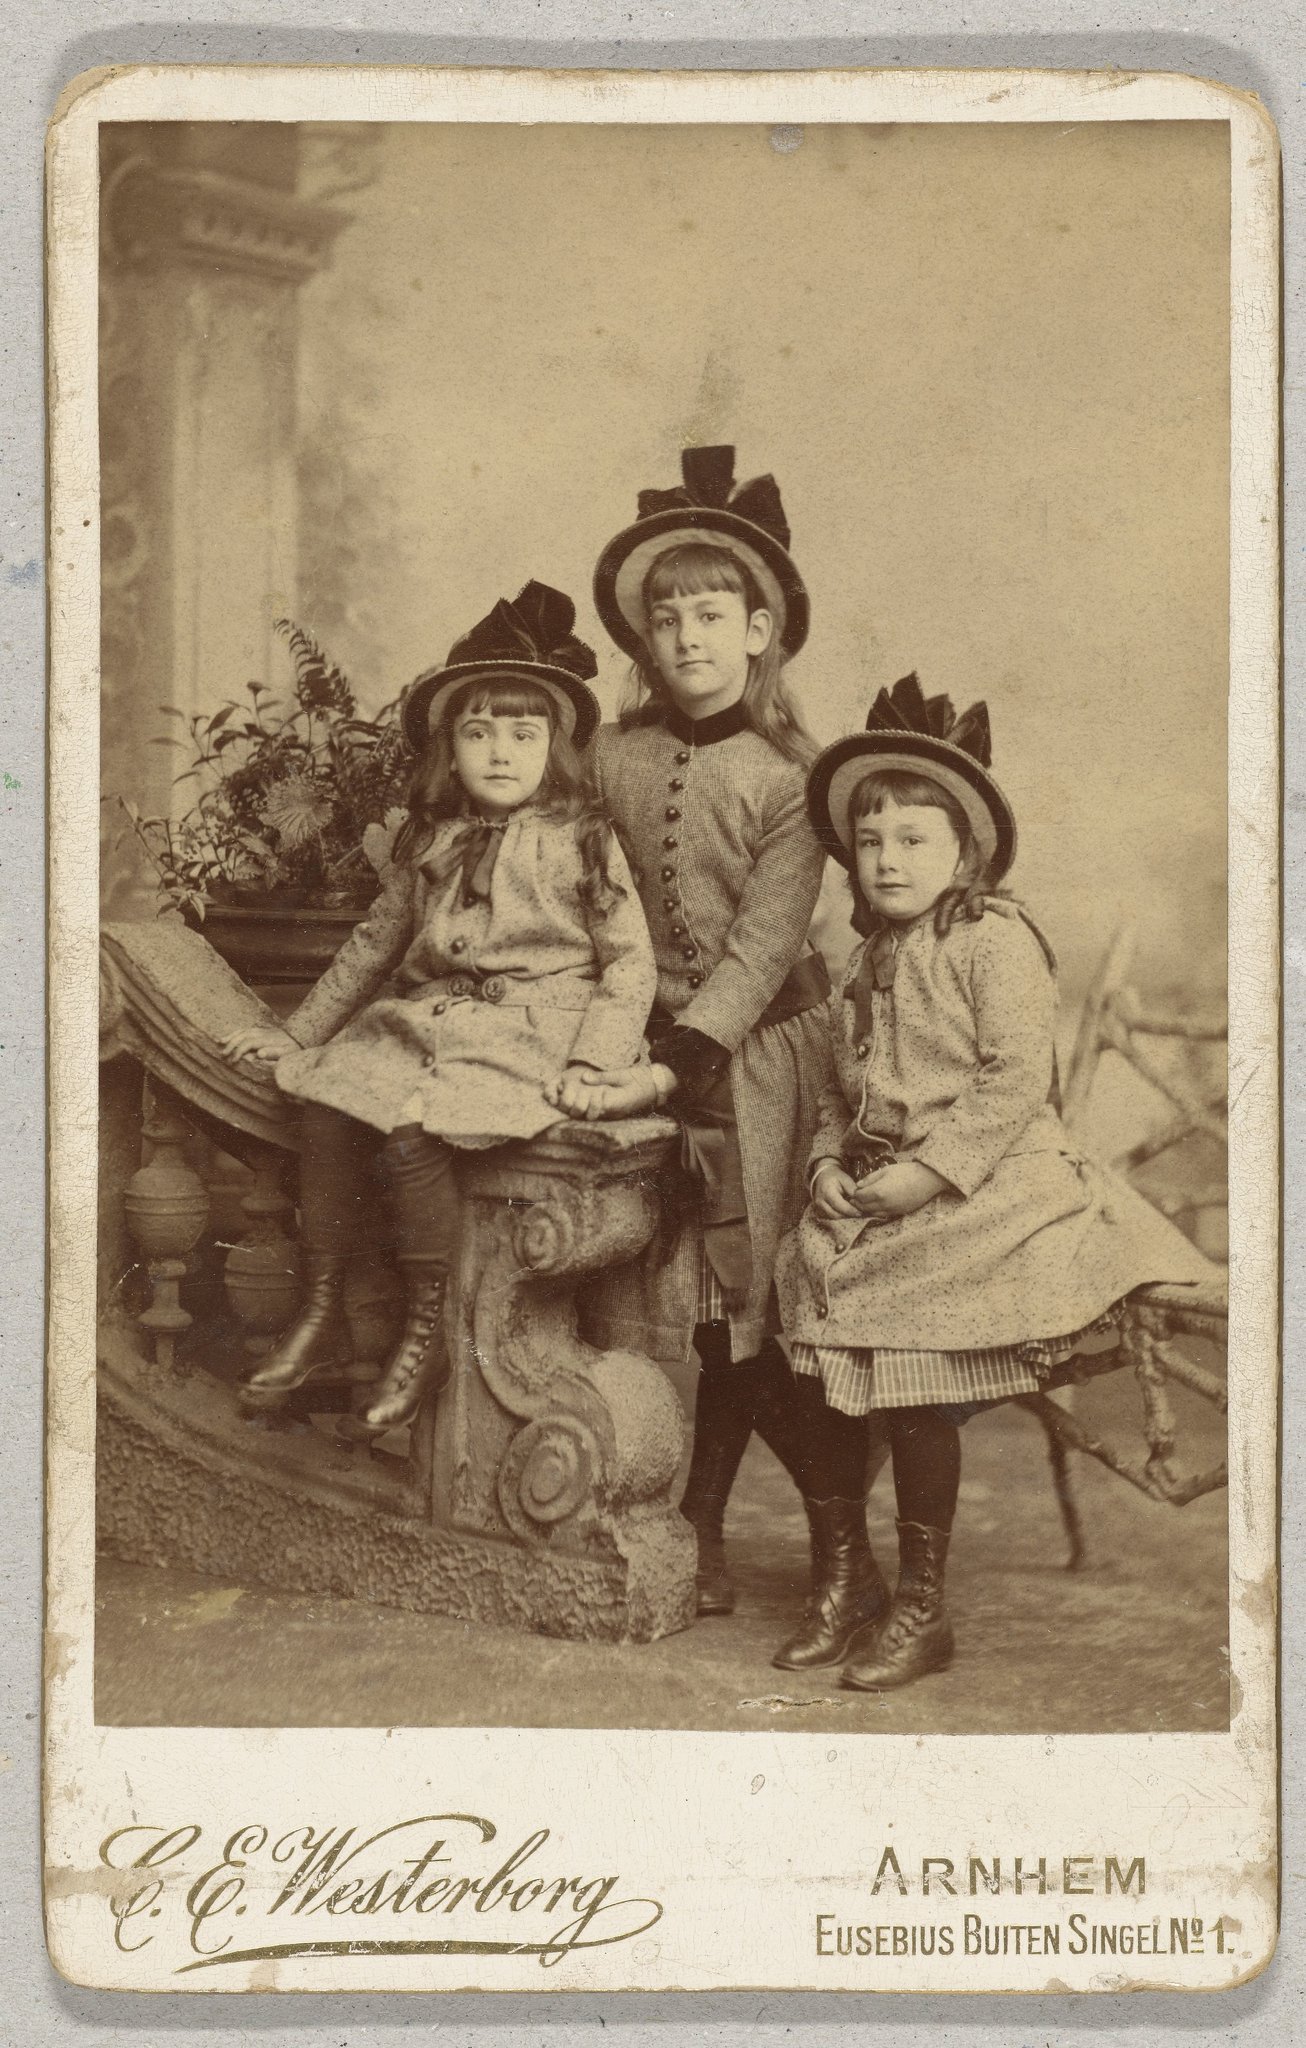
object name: cabinet photograph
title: Portret van Adeh, Ida en Kitty van Braam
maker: carel eduard westerborg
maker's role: fotograaf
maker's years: 1842-1916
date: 1880-1900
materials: cardboard, paper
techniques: albumen print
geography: arnhem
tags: arnhem, historical person (with name) - bb - woman - historical person (with name) portrayed in a group, in a group-portrait, netherlands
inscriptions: signature: ‘C.E. Westerborg Arnhem Eusebius Buiten Singel 1’